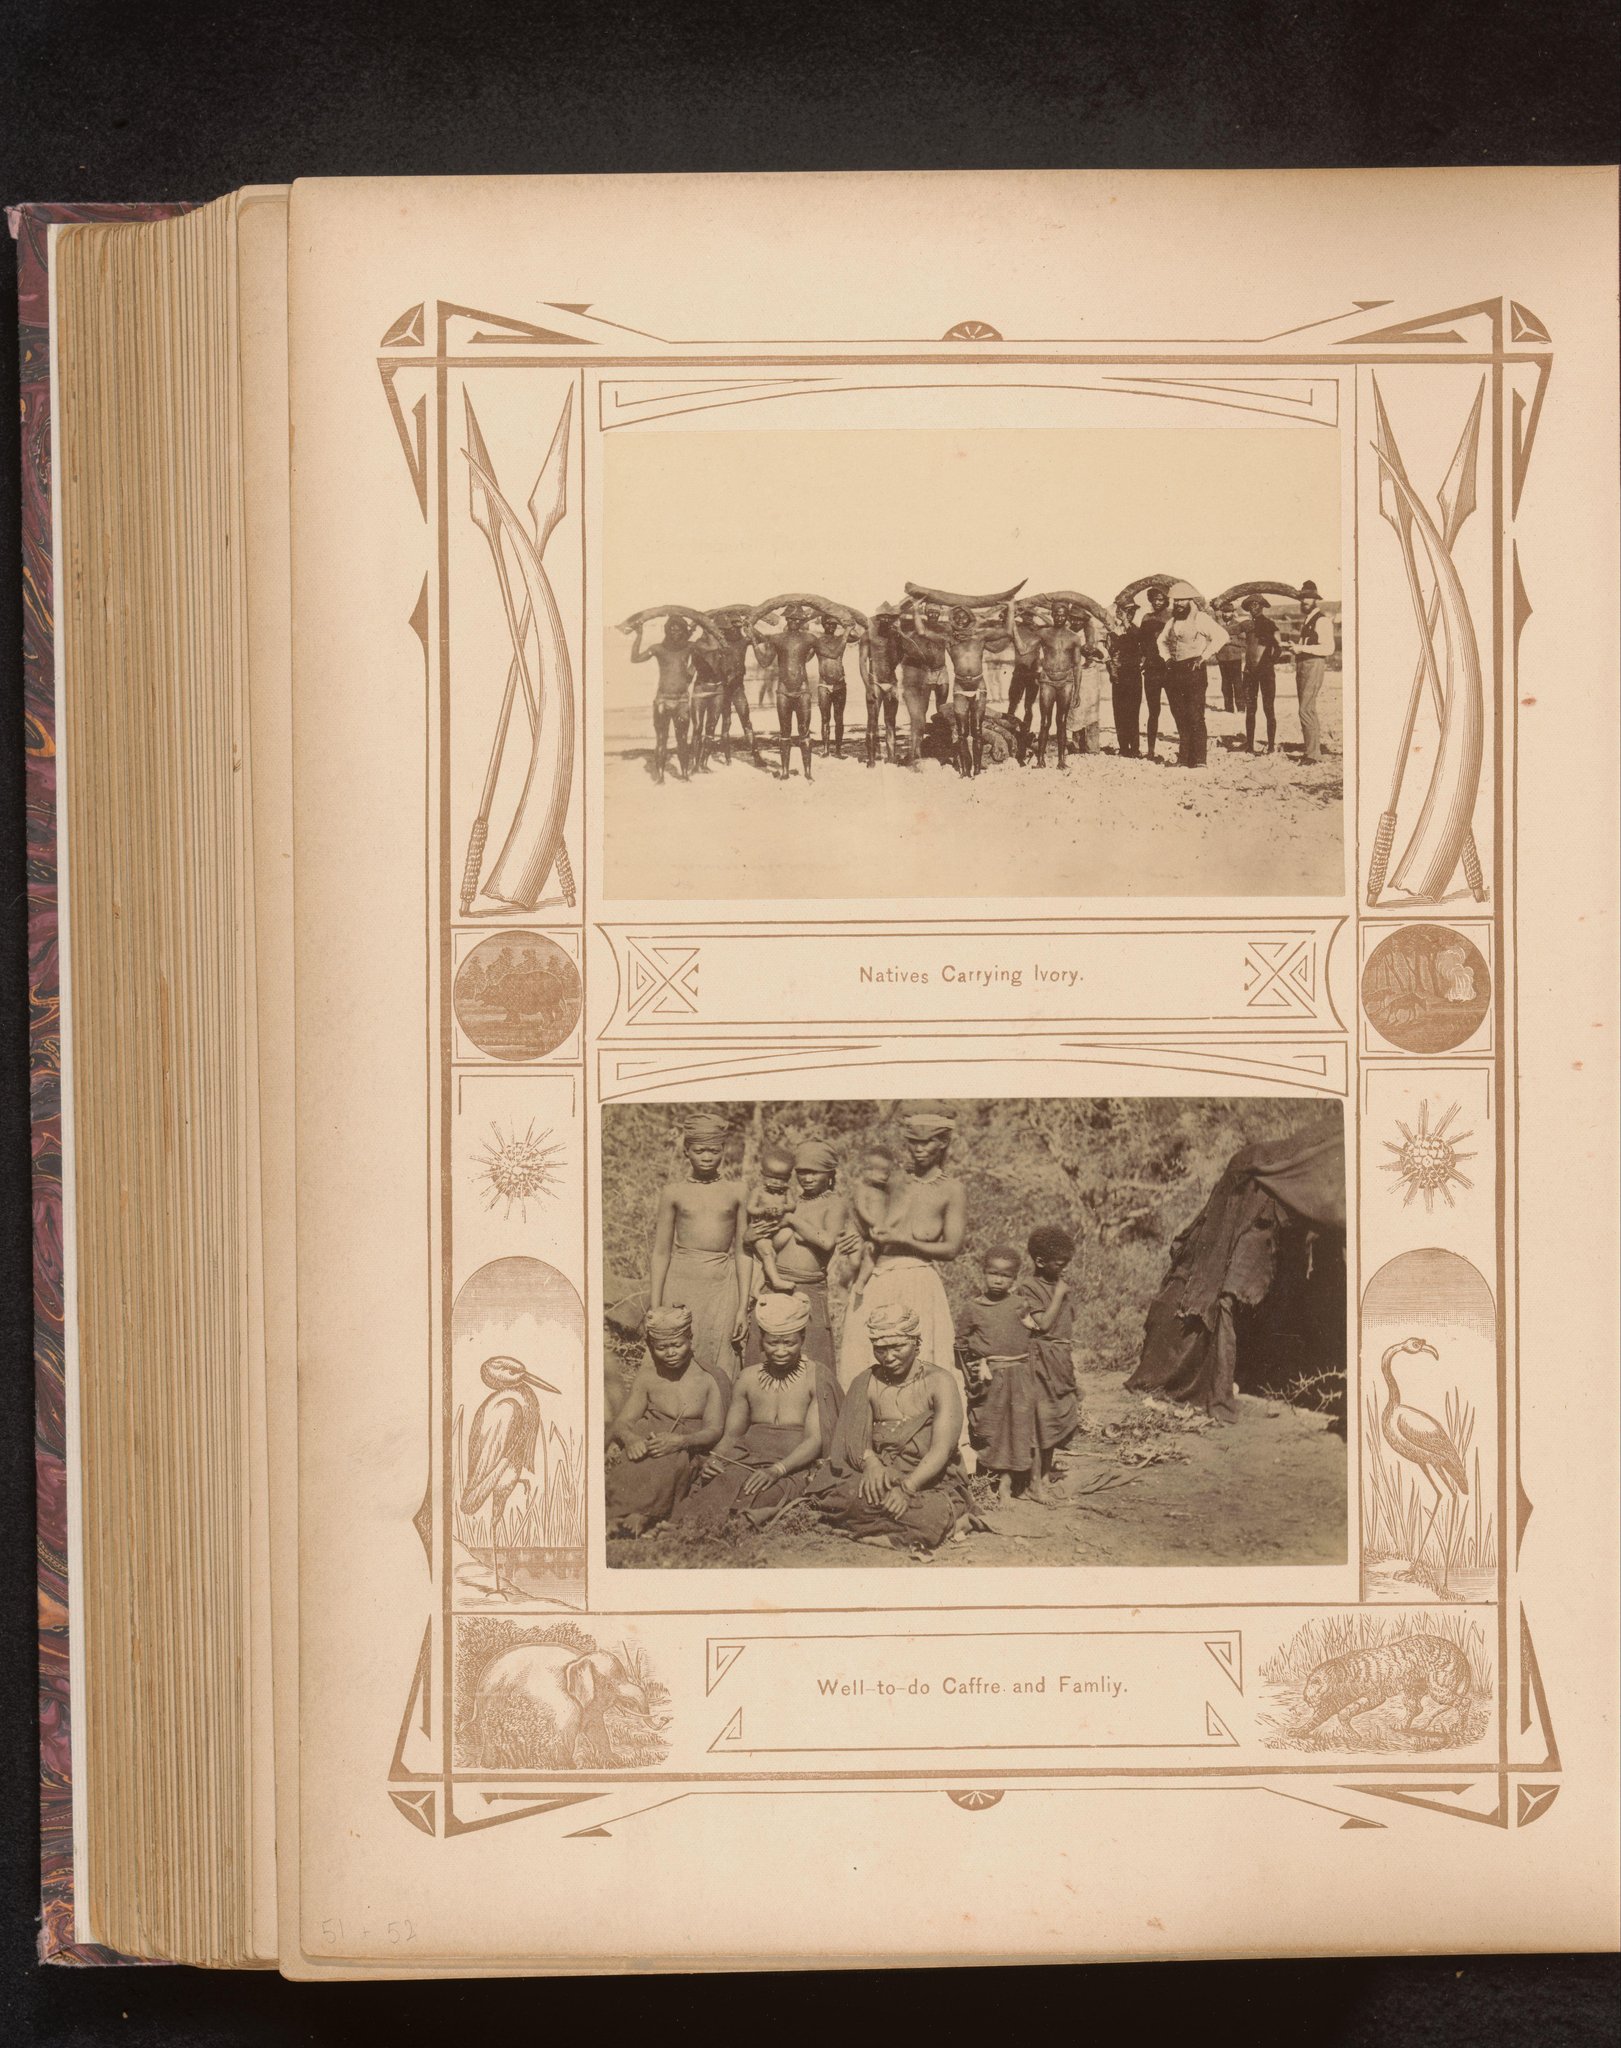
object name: photograph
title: Groep onbekende mannen met slagtanden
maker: Anonymous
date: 1877-1882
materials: photographic support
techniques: albumen print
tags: trunked animals: elephant (+ fang, tusk), anonymous historical persons portrayed in a group, in a group-portrait